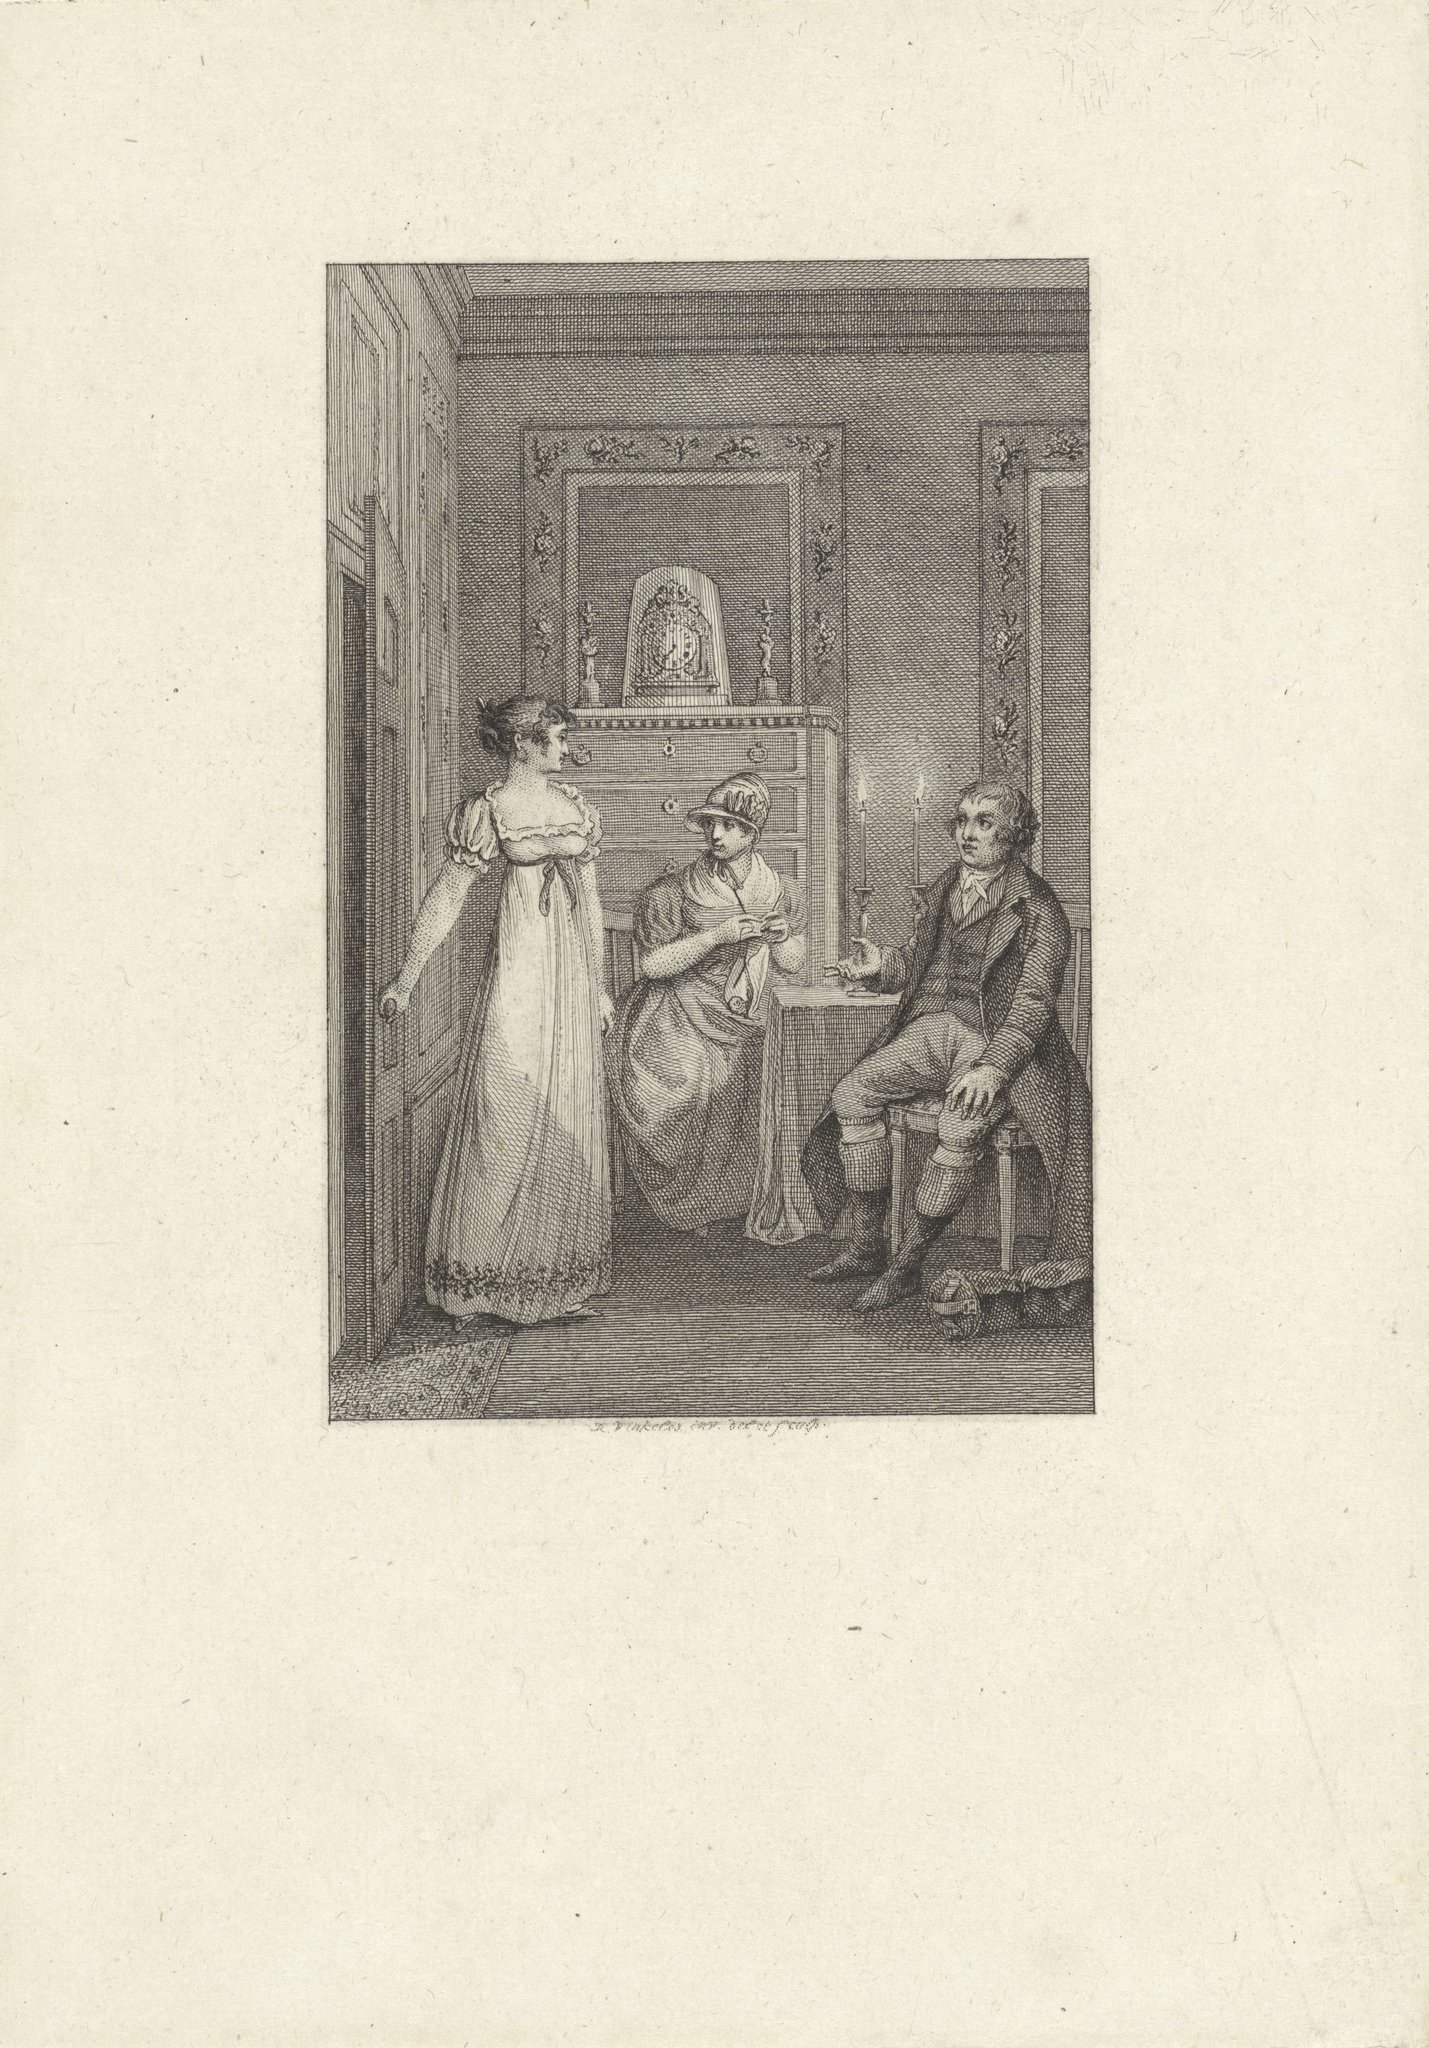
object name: print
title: Man en twee vrouwen in een vertrek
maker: reinier vinkeles (i)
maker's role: draughtsman, print maker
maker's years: 1741-1816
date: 1809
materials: paper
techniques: engraving, etching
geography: amsterdam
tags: adult man, candle, knitting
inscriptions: collector's mark: Lugt 2228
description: In een vertrek is een man in gesprek met een jonge vrouw die de deurknop vasthoudt. Een tweede vrouw zit aan tafel te breien. De prent is een illustratie voor een boek over de vier 'tijdperken' van de man, van het tijdperk 'de man'.